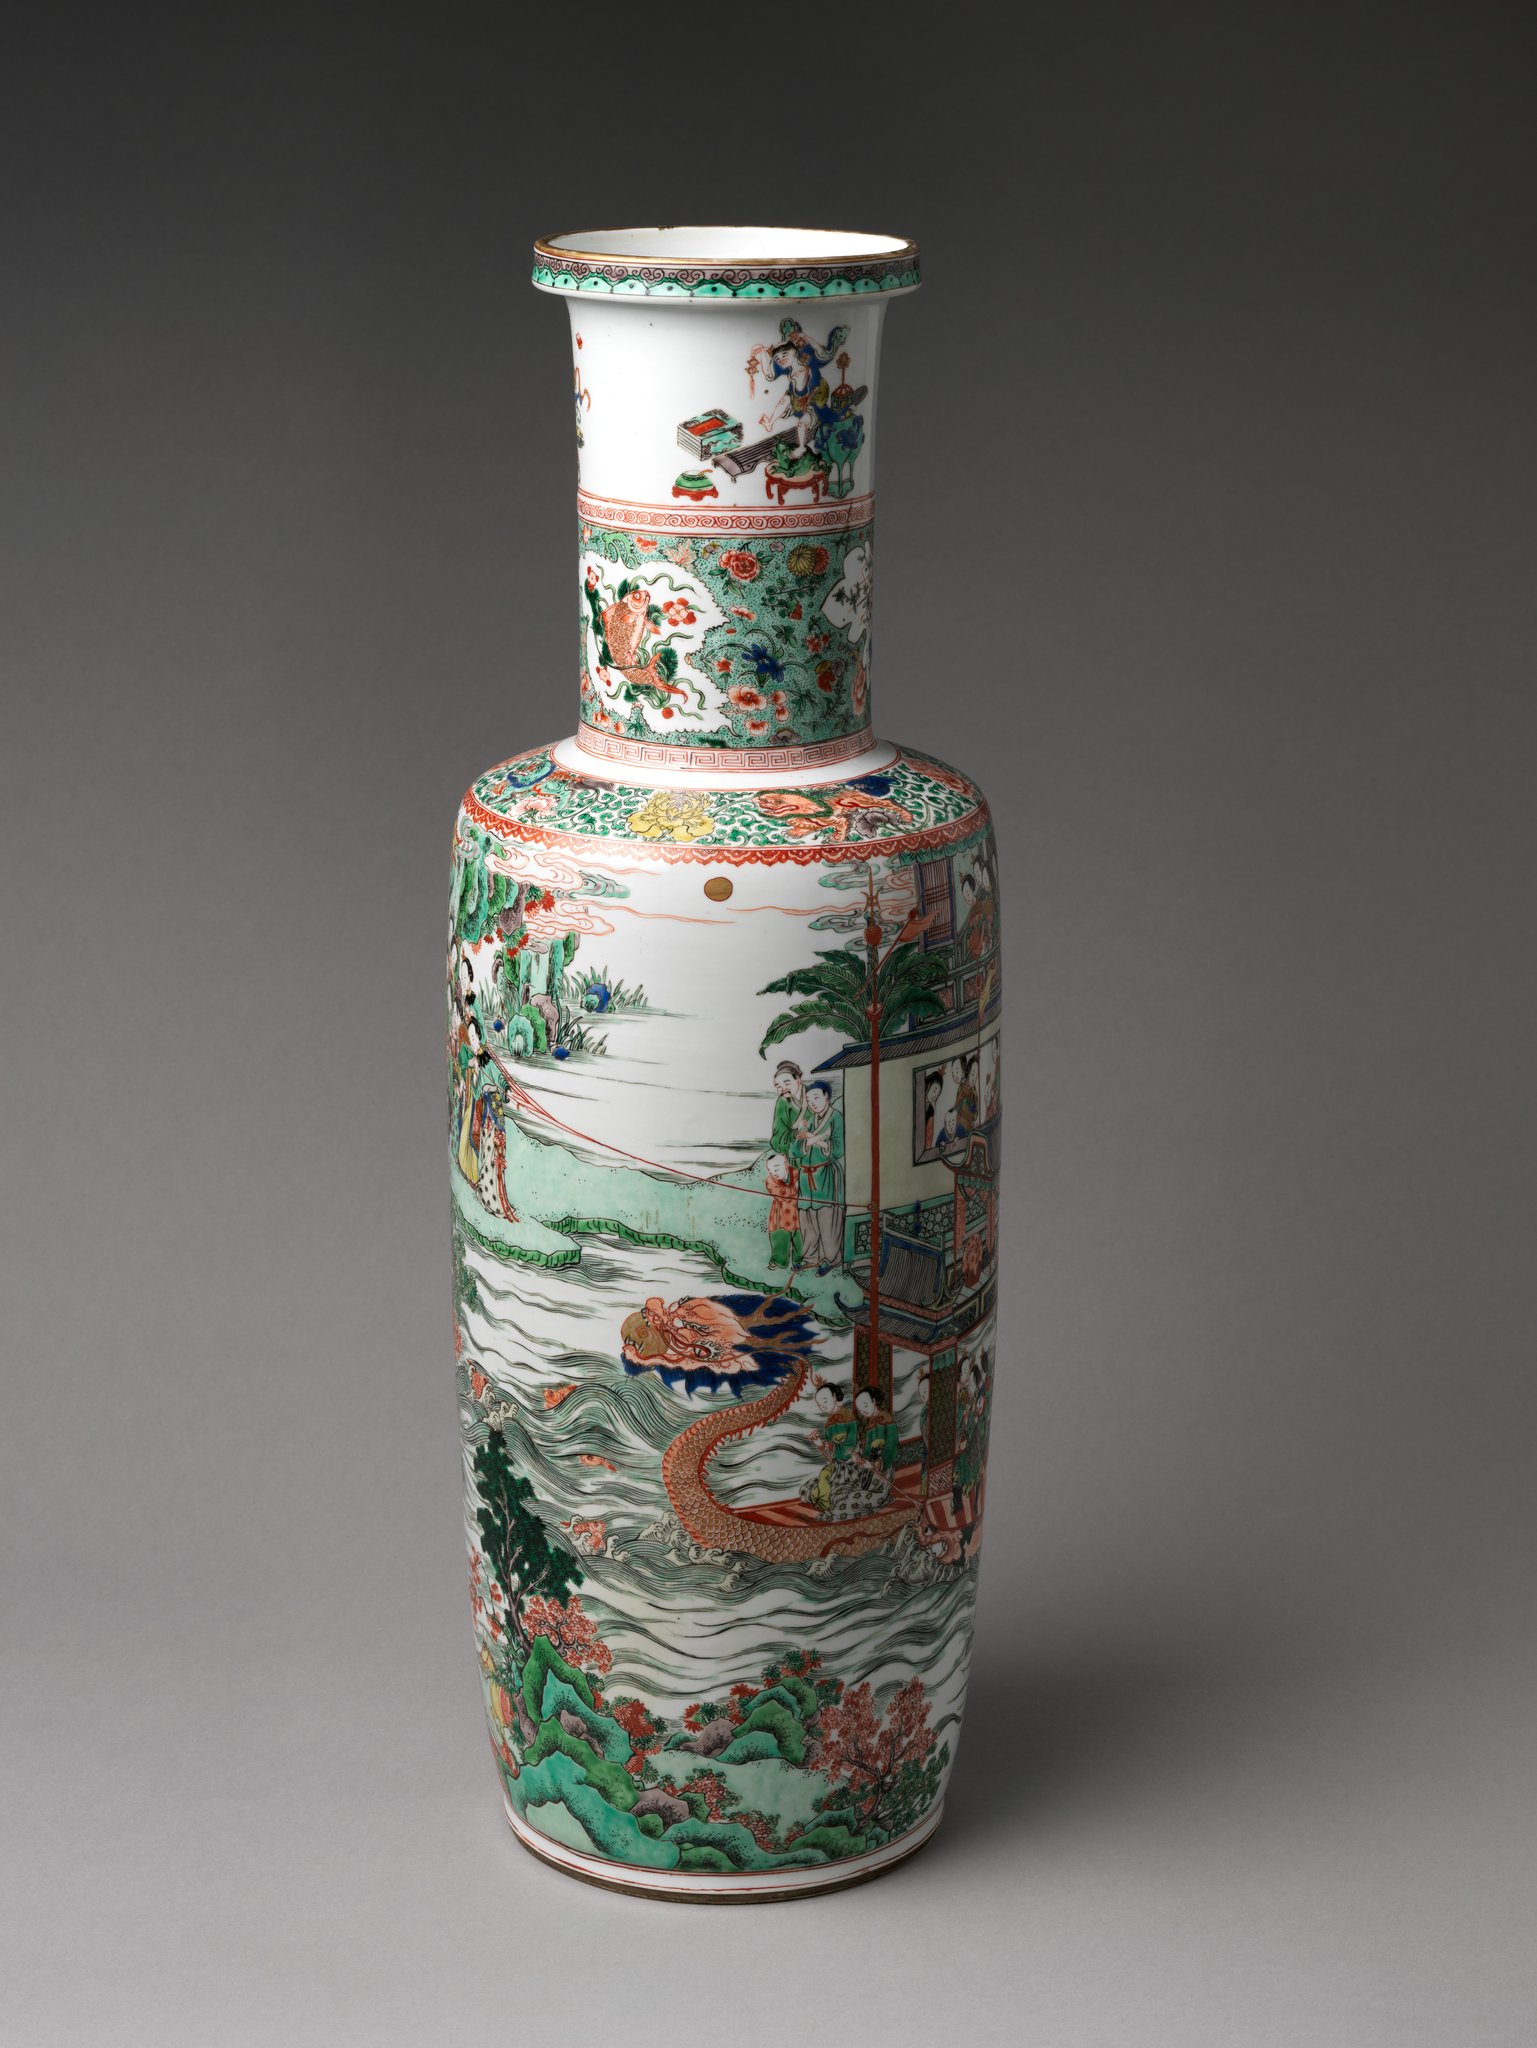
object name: vase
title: Vase with Scene from the Dragon Boat Festival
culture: chinese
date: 1667-1733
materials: enamel, glaze, porcelain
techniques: painting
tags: human figures,dragons,boats